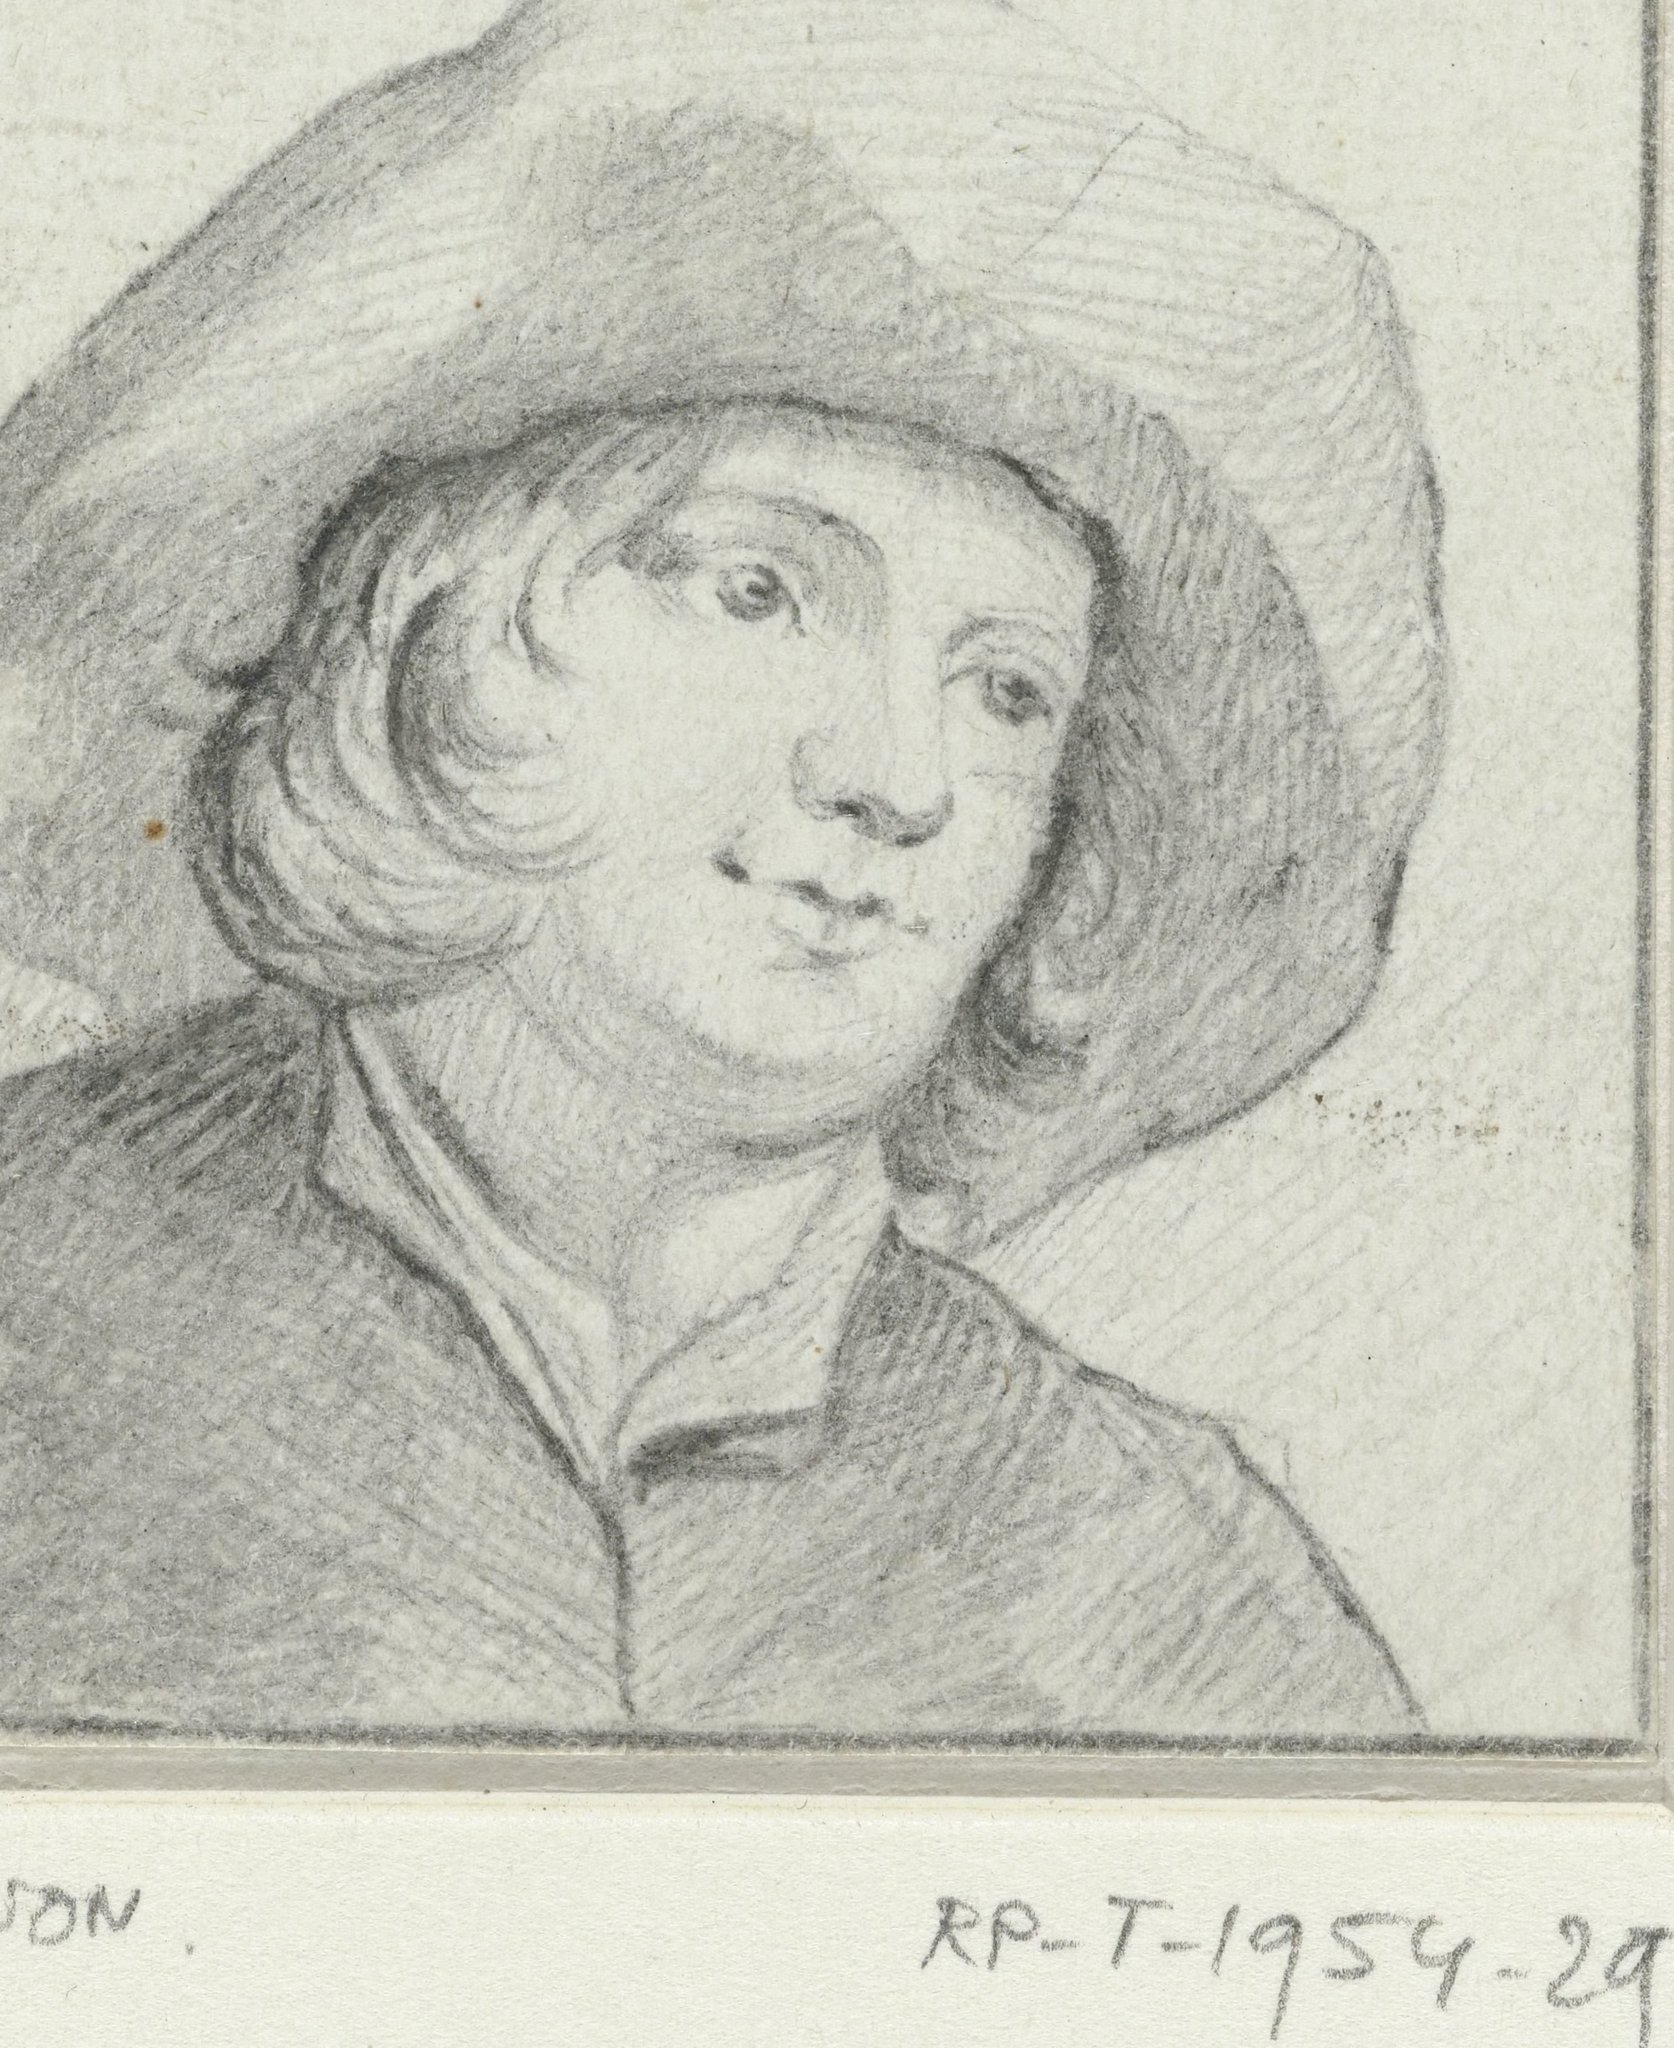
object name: drawing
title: Portret van de schilder Joost van Graesbeek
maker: Anonymous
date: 1700-1800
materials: paper, pencil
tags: painter, historical persons, portrait, self-portrait of painter, portrait, self-portrait of artist